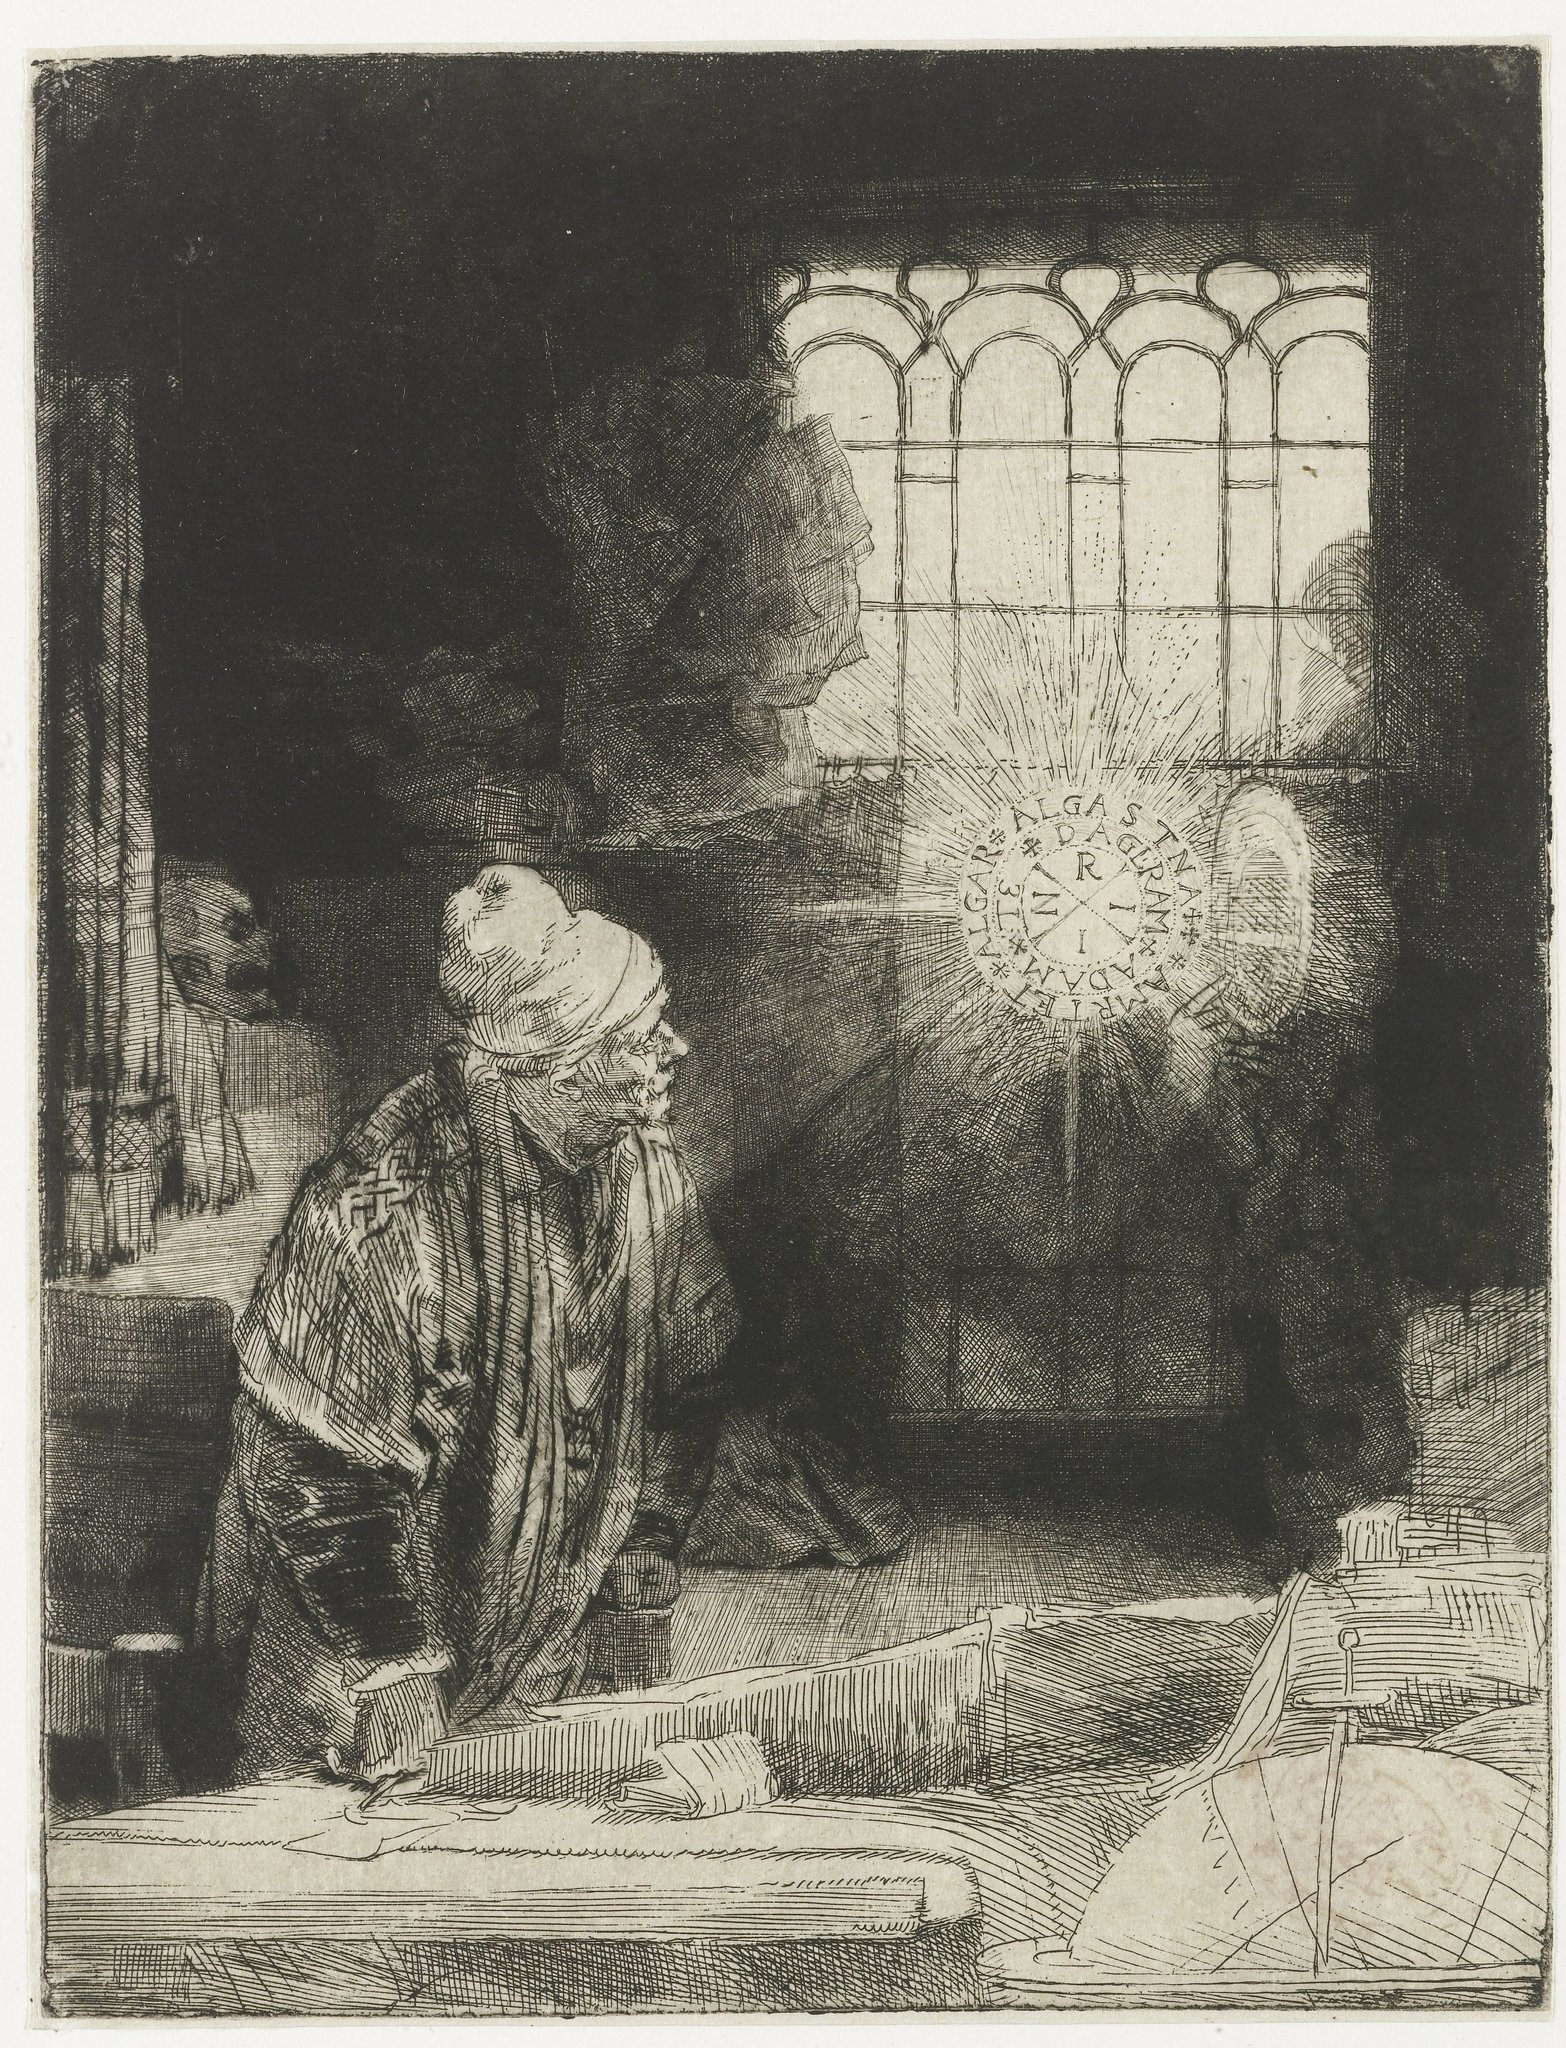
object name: print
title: A scholar in his study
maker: rembrandt van rijn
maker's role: draughtsman, painter, print maker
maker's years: 1606-1669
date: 1652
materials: paper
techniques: drypoint, etching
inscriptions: collector's mark: Lugt 240